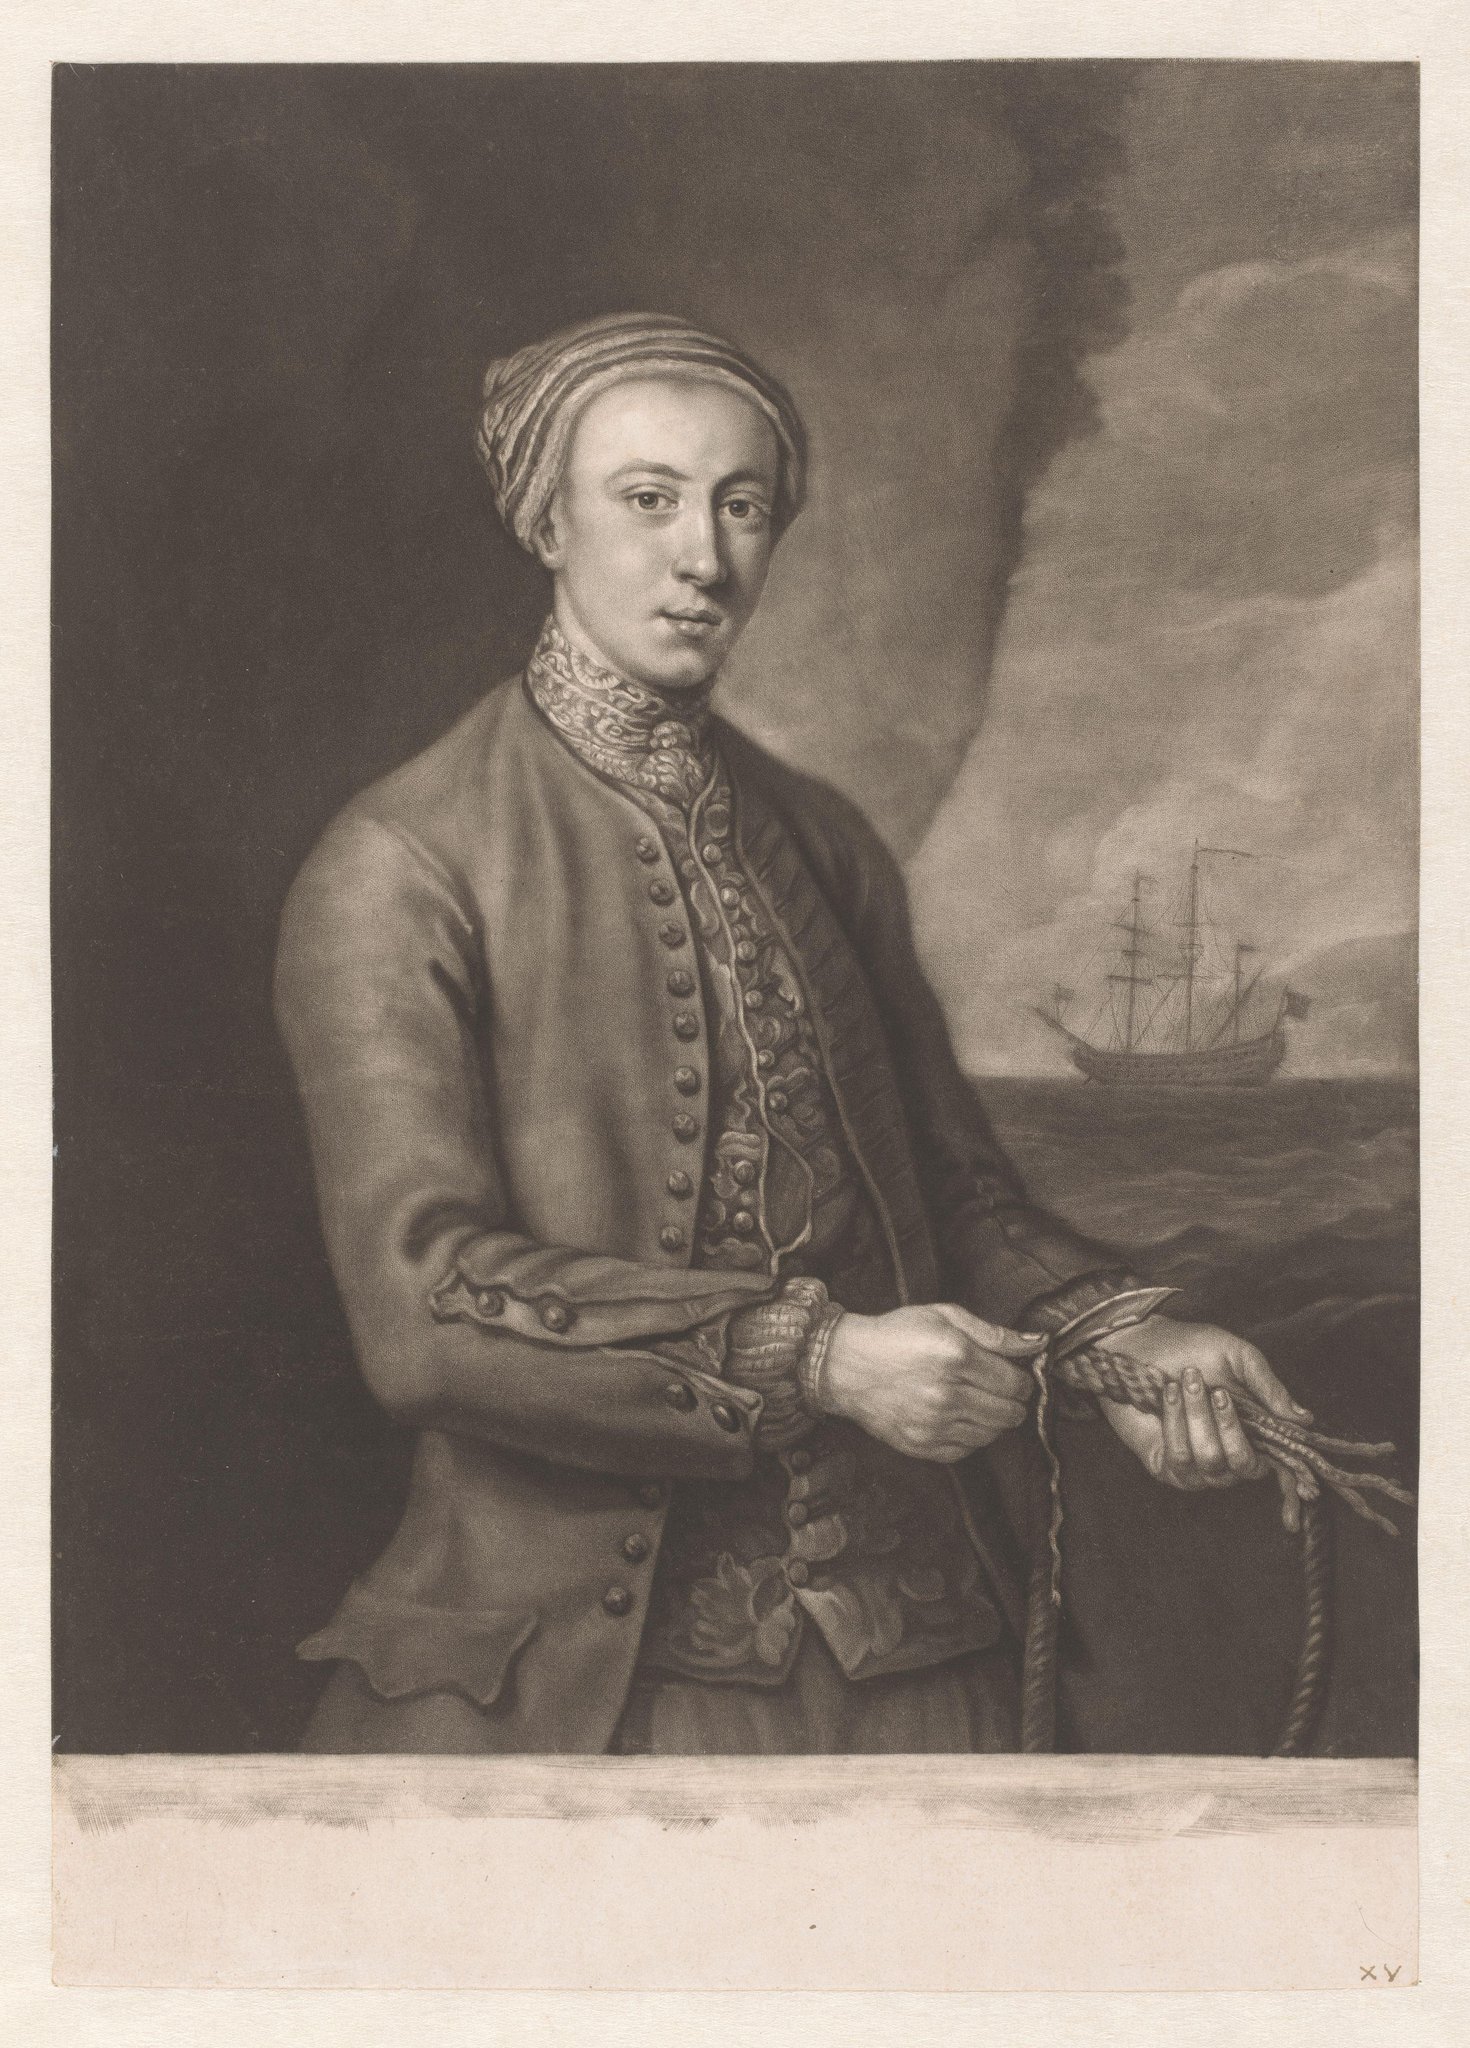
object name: print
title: Portret van Andrew Wilkinson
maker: james mcardell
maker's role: print maker, publisher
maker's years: 1728-1765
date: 1755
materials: paper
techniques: mezzotint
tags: sailing-ship, sailing-boat, seaman (with name of rank), historical persons, tools, aids, implements ~ crafts and industries: rope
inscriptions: collector's mark: Lugt 240